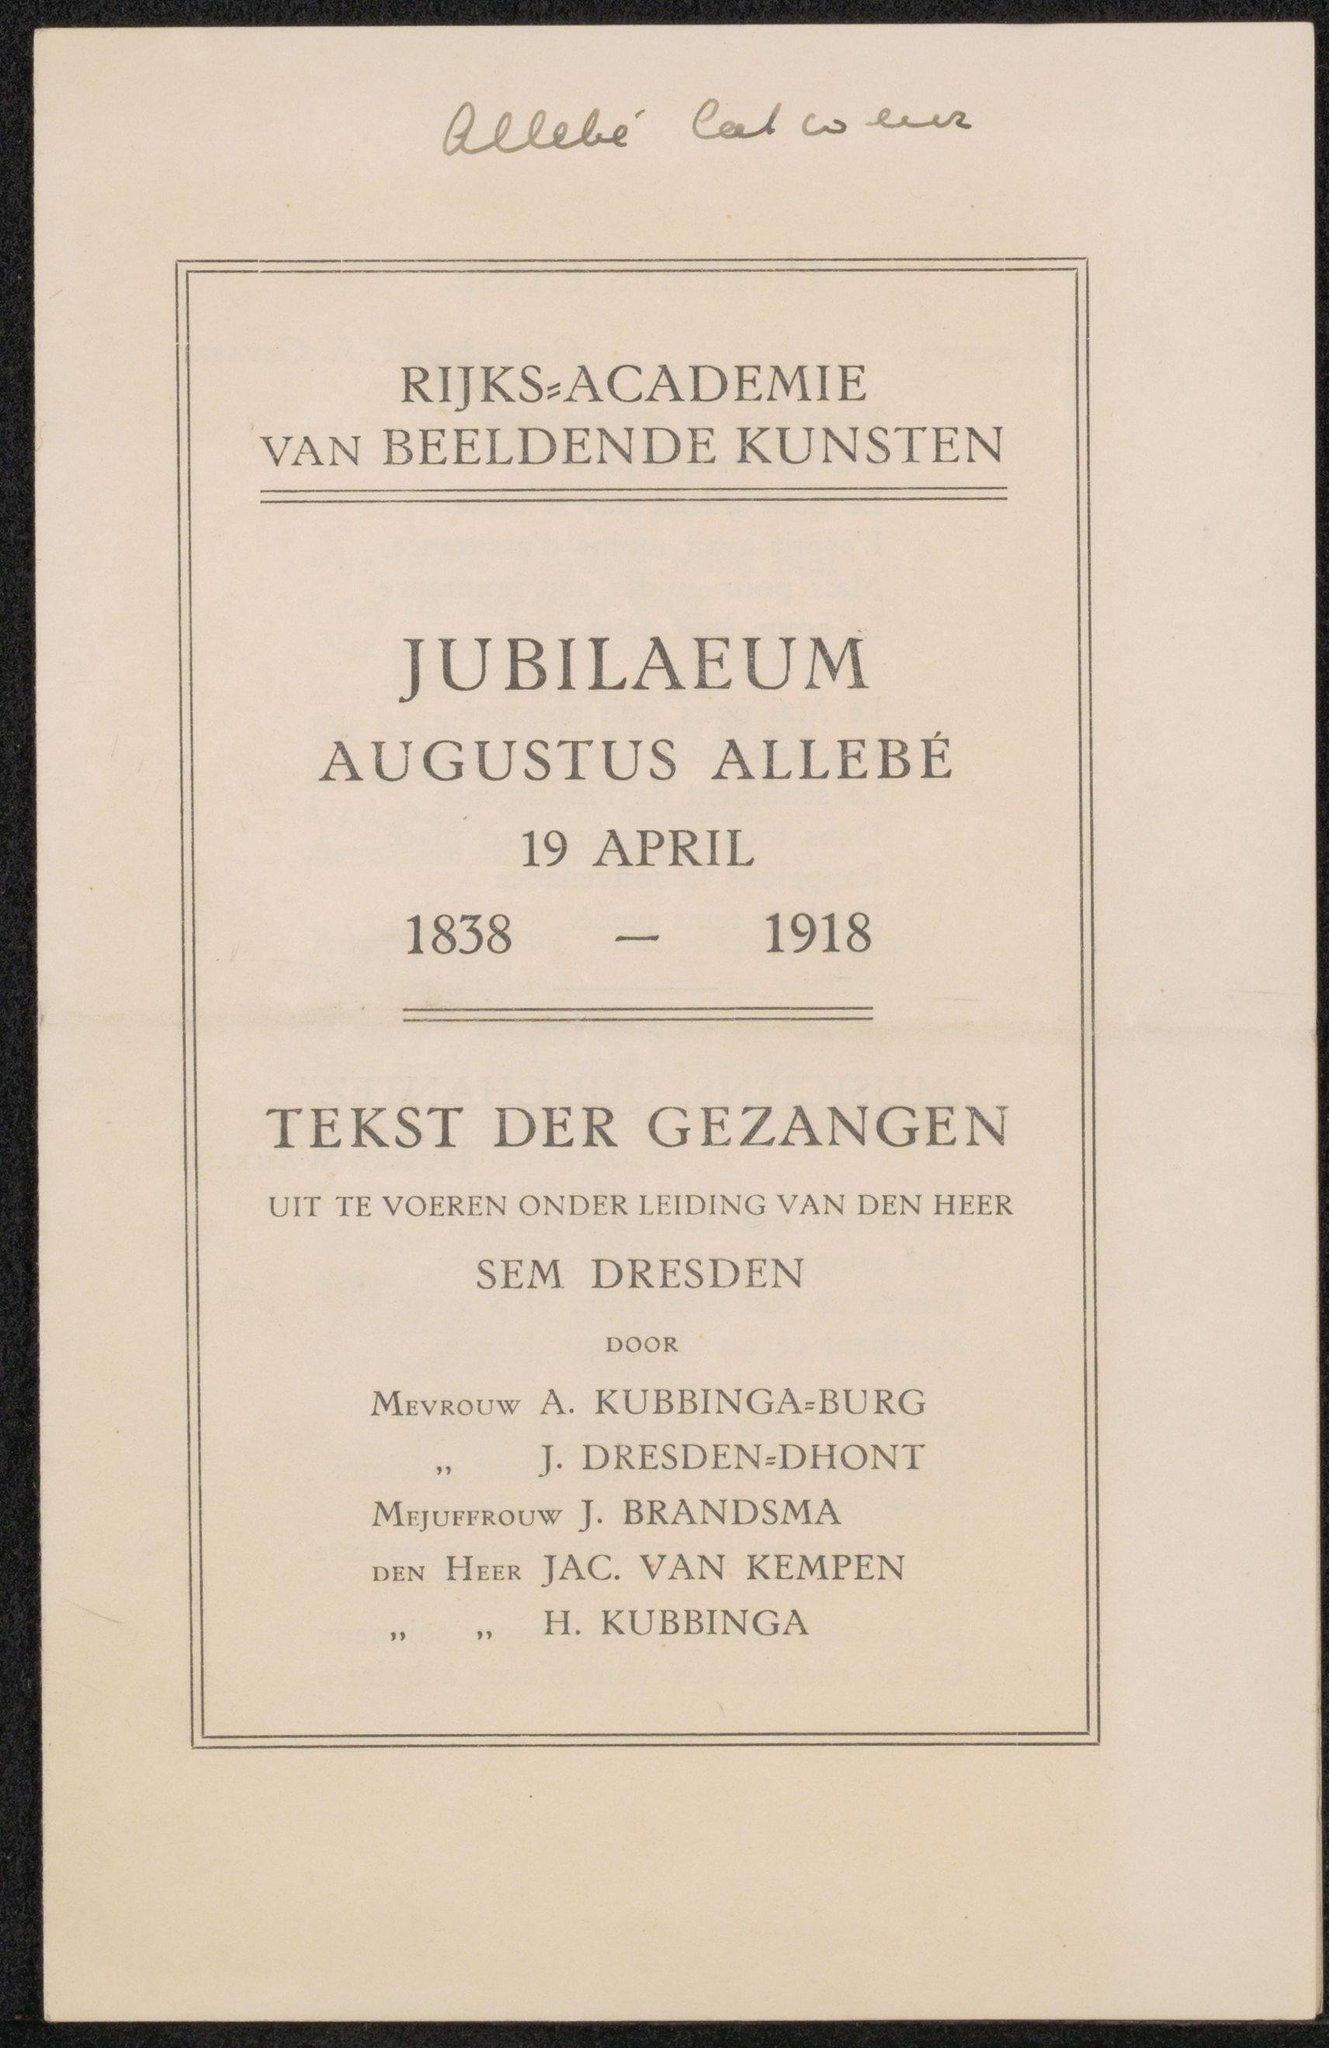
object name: programma, programmaboekje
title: Programma voor het jubileum van August Allebé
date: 1918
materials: paper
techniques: printing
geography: amsterdam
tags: amsterdam, august allebé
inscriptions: collector's mark: ‘RPK’